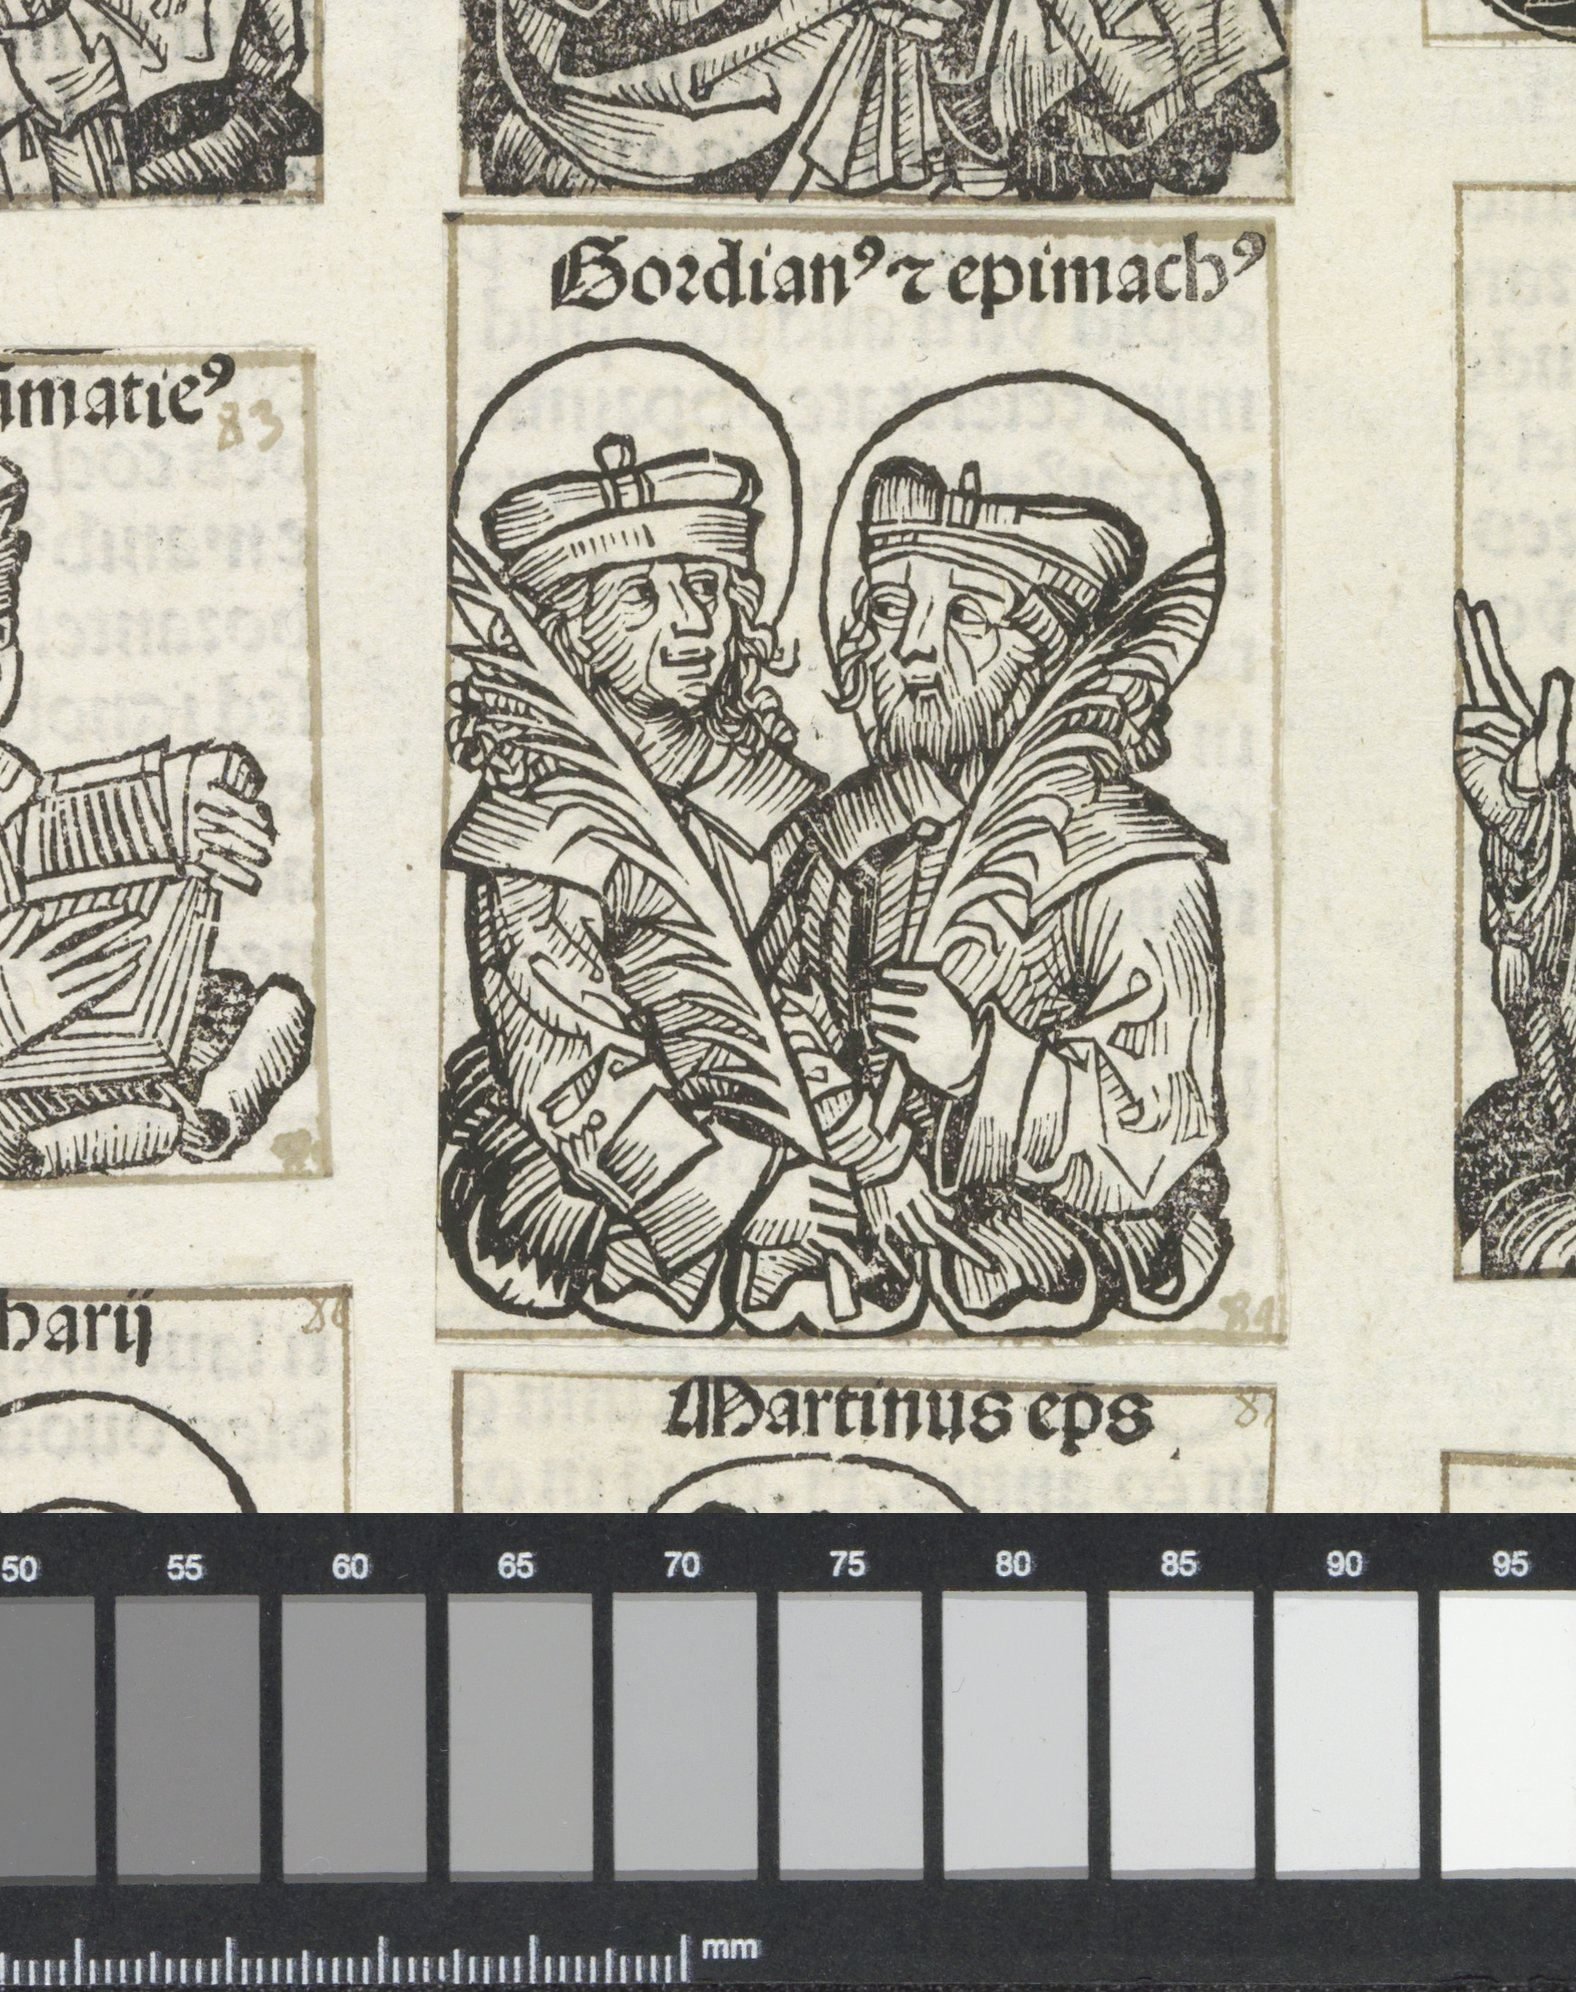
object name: print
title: Gordianus en Epimachus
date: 1493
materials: paper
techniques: letterpress printing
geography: nuremberg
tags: saints, martyr(s) (often with palm-branches)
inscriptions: inscription: ‘84’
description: De houtsnede wordt herhaaldelijk gebruikt als boekillustratie in de Liber Chronicarum (of Neurenbergkroniek) van Hartmann Schedel, verschenen in het Latijn en Duits in 1493. Zie de Latijnse uitgave, folio 132v.